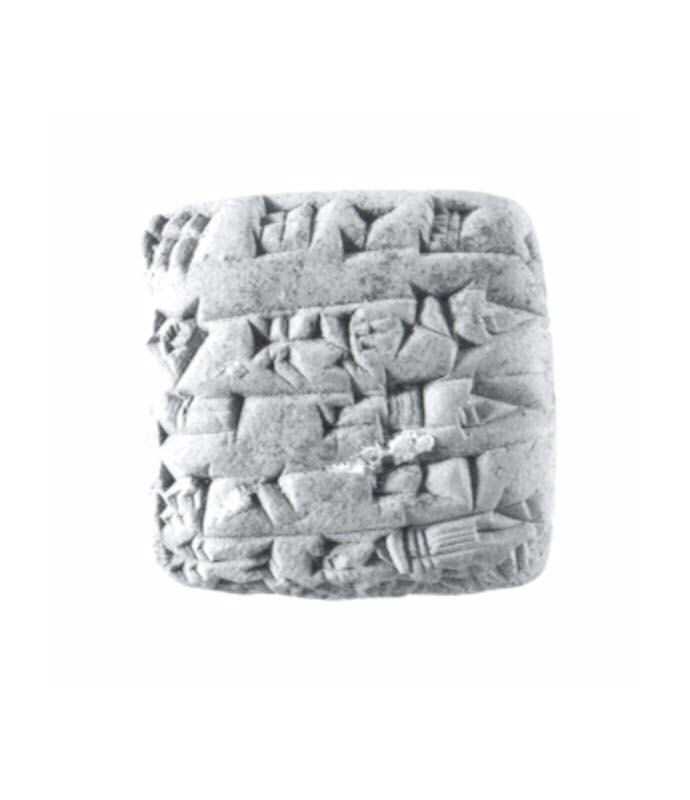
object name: cuneiform tablet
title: Cuneiform tablet: receipt of unshorn sheep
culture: neo-sumerian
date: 2060 BCE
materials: clay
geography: mesopotamia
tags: sheep